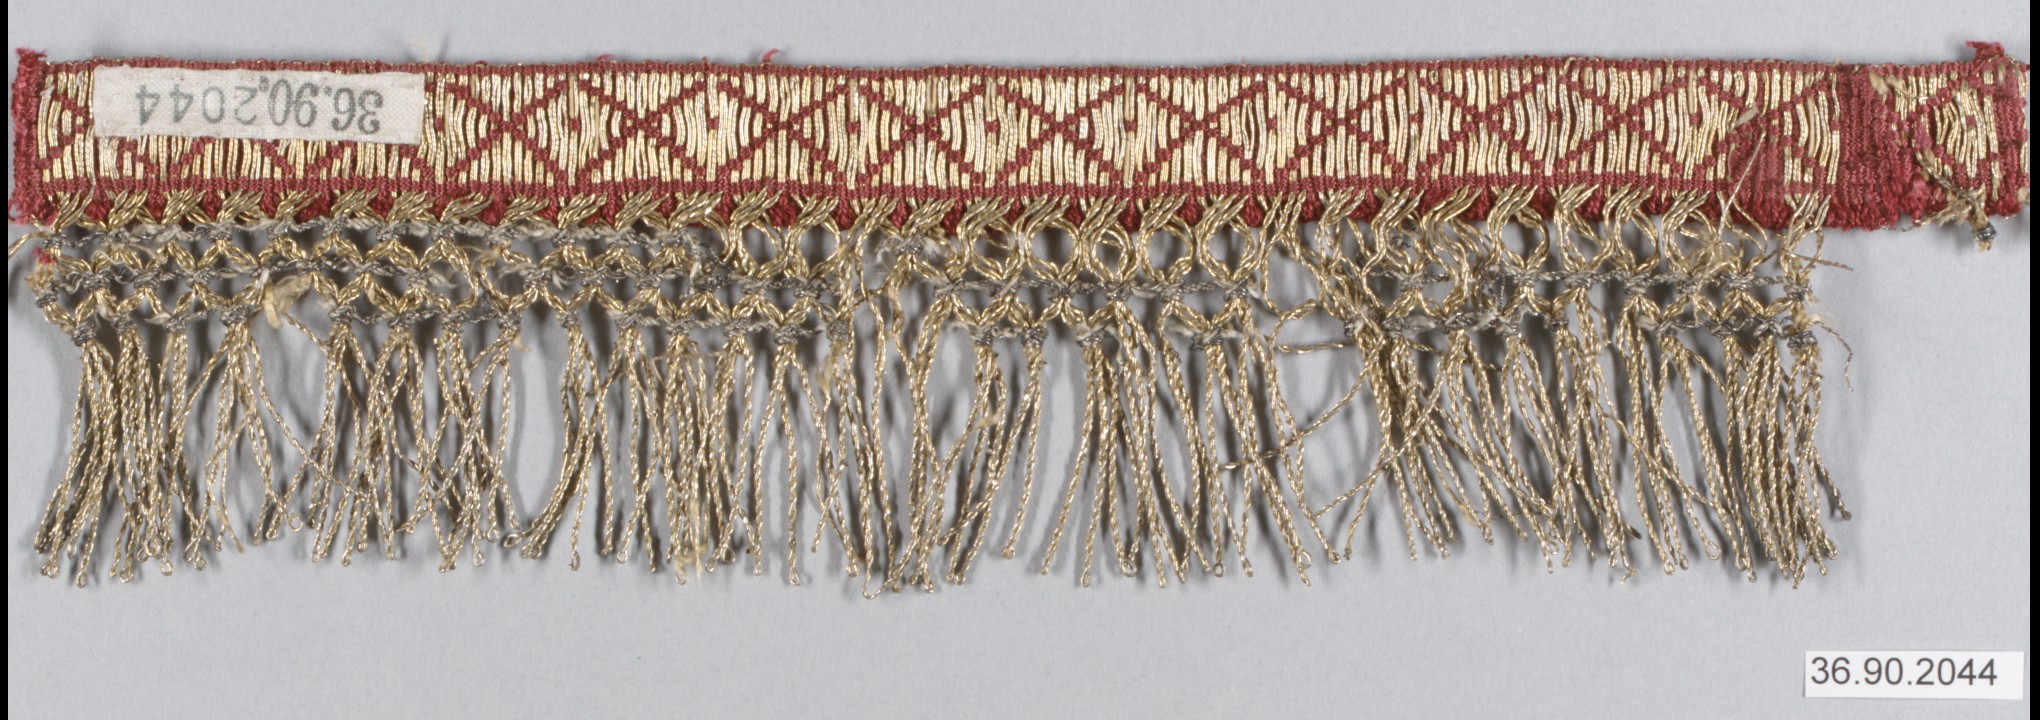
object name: fringe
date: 1801-1833